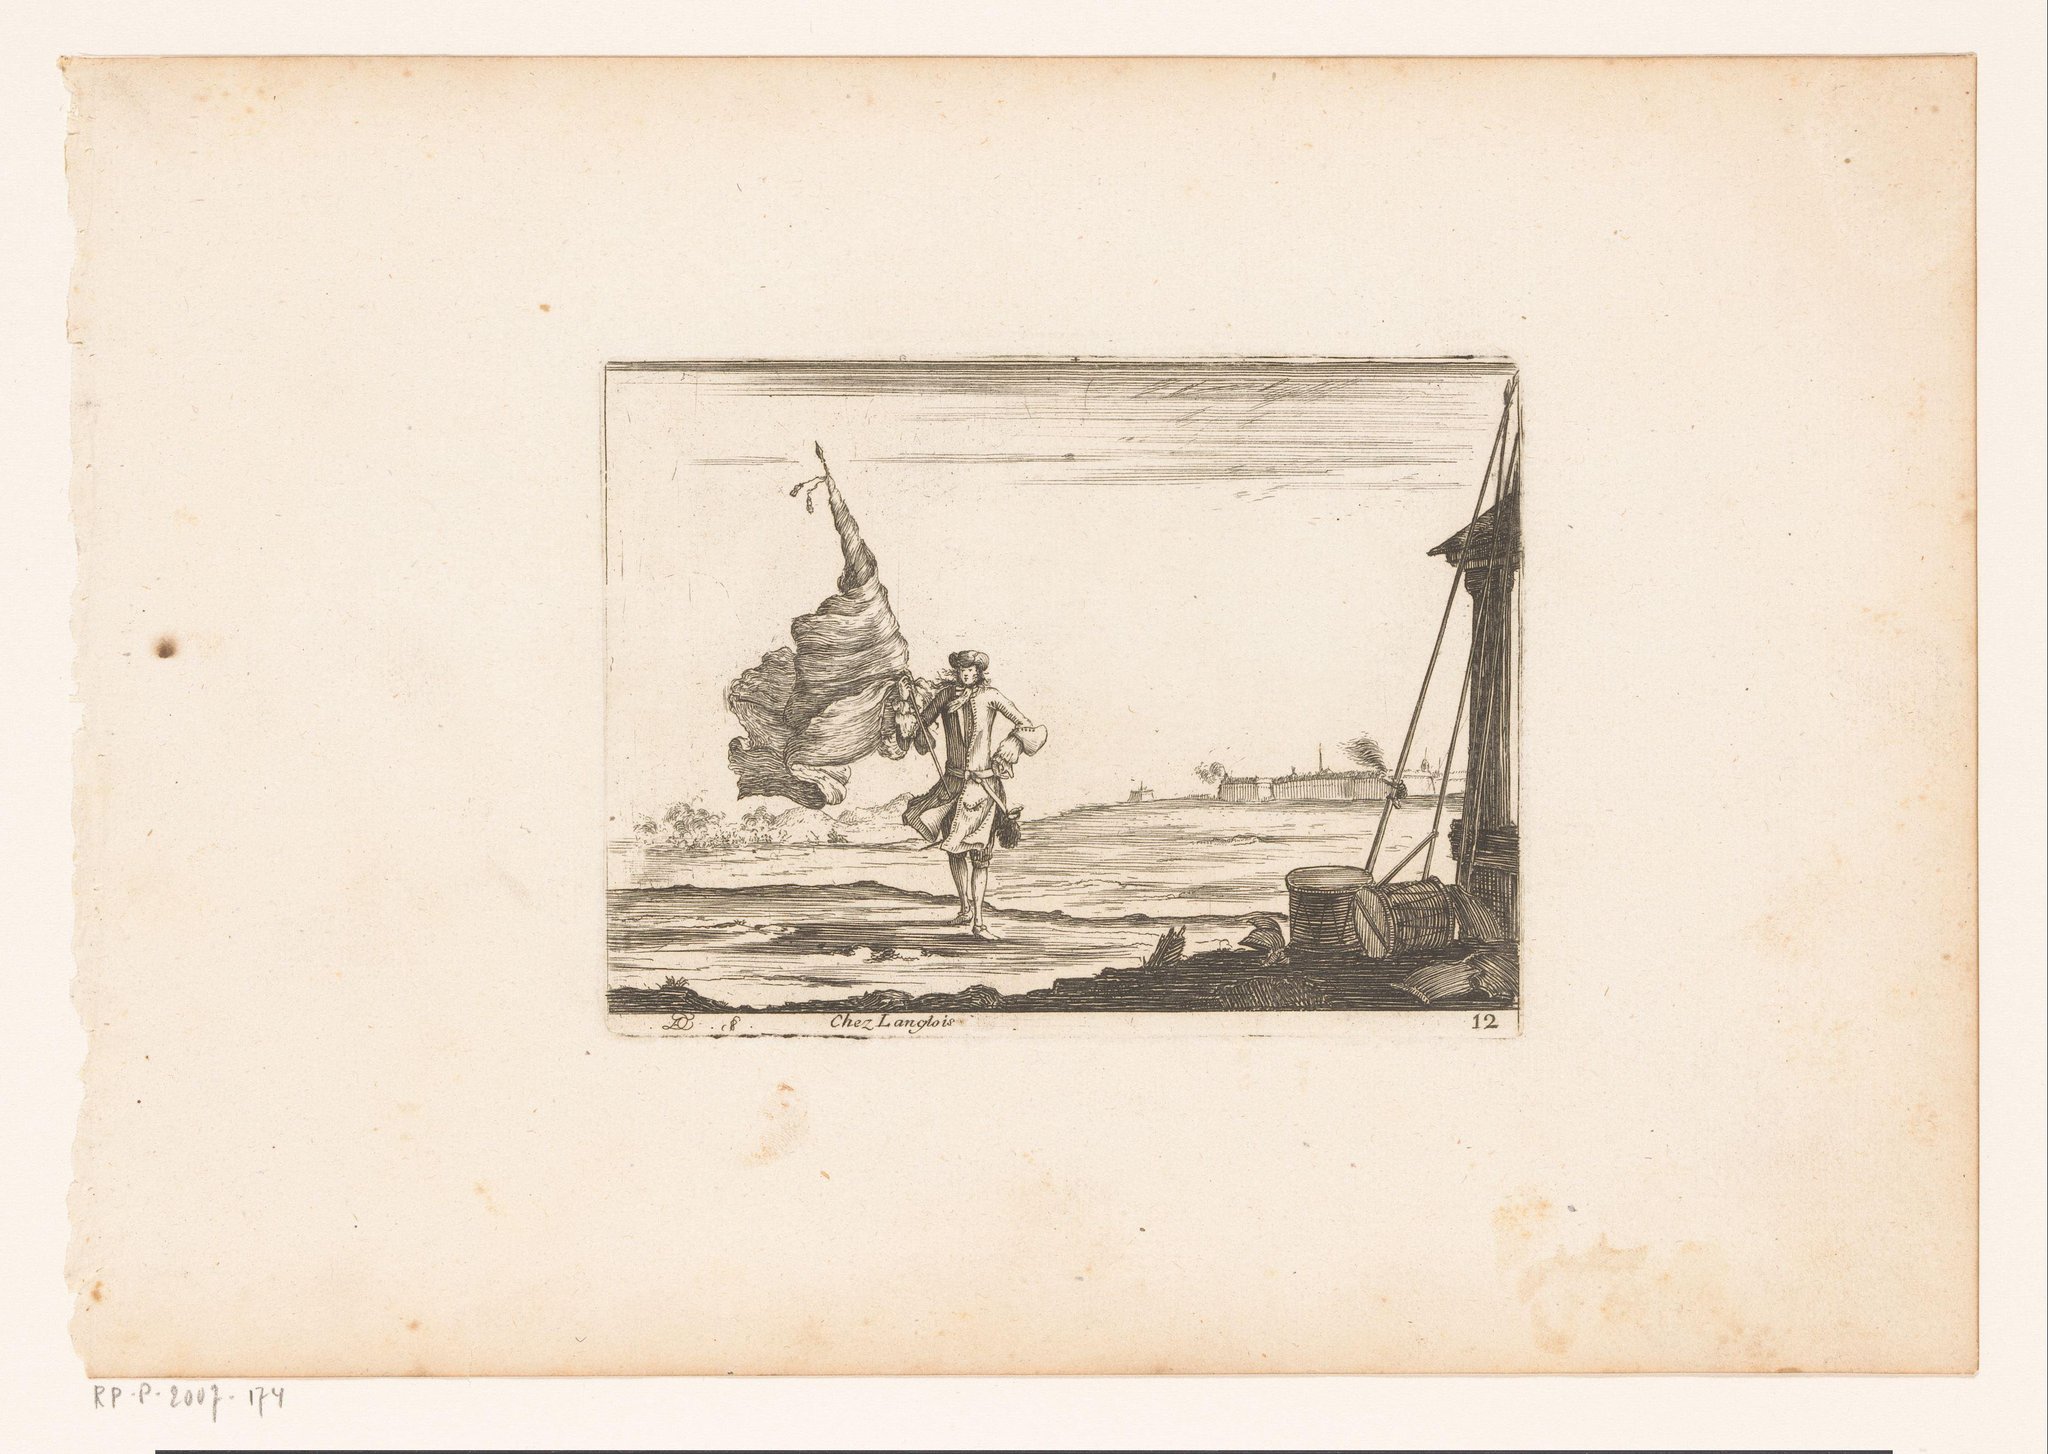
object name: print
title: Diverses figures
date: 1670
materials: paper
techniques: etching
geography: paris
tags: percussion instruments - cc - out of doors, standard-bearer, flag-bearer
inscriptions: collector's mark: Lugt 2228, collector's mark: Lugt 2760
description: Maakt deel uit van een serie van twaalf prenten met verschillende figuren, uitgegeven door Langlois in Parijs.